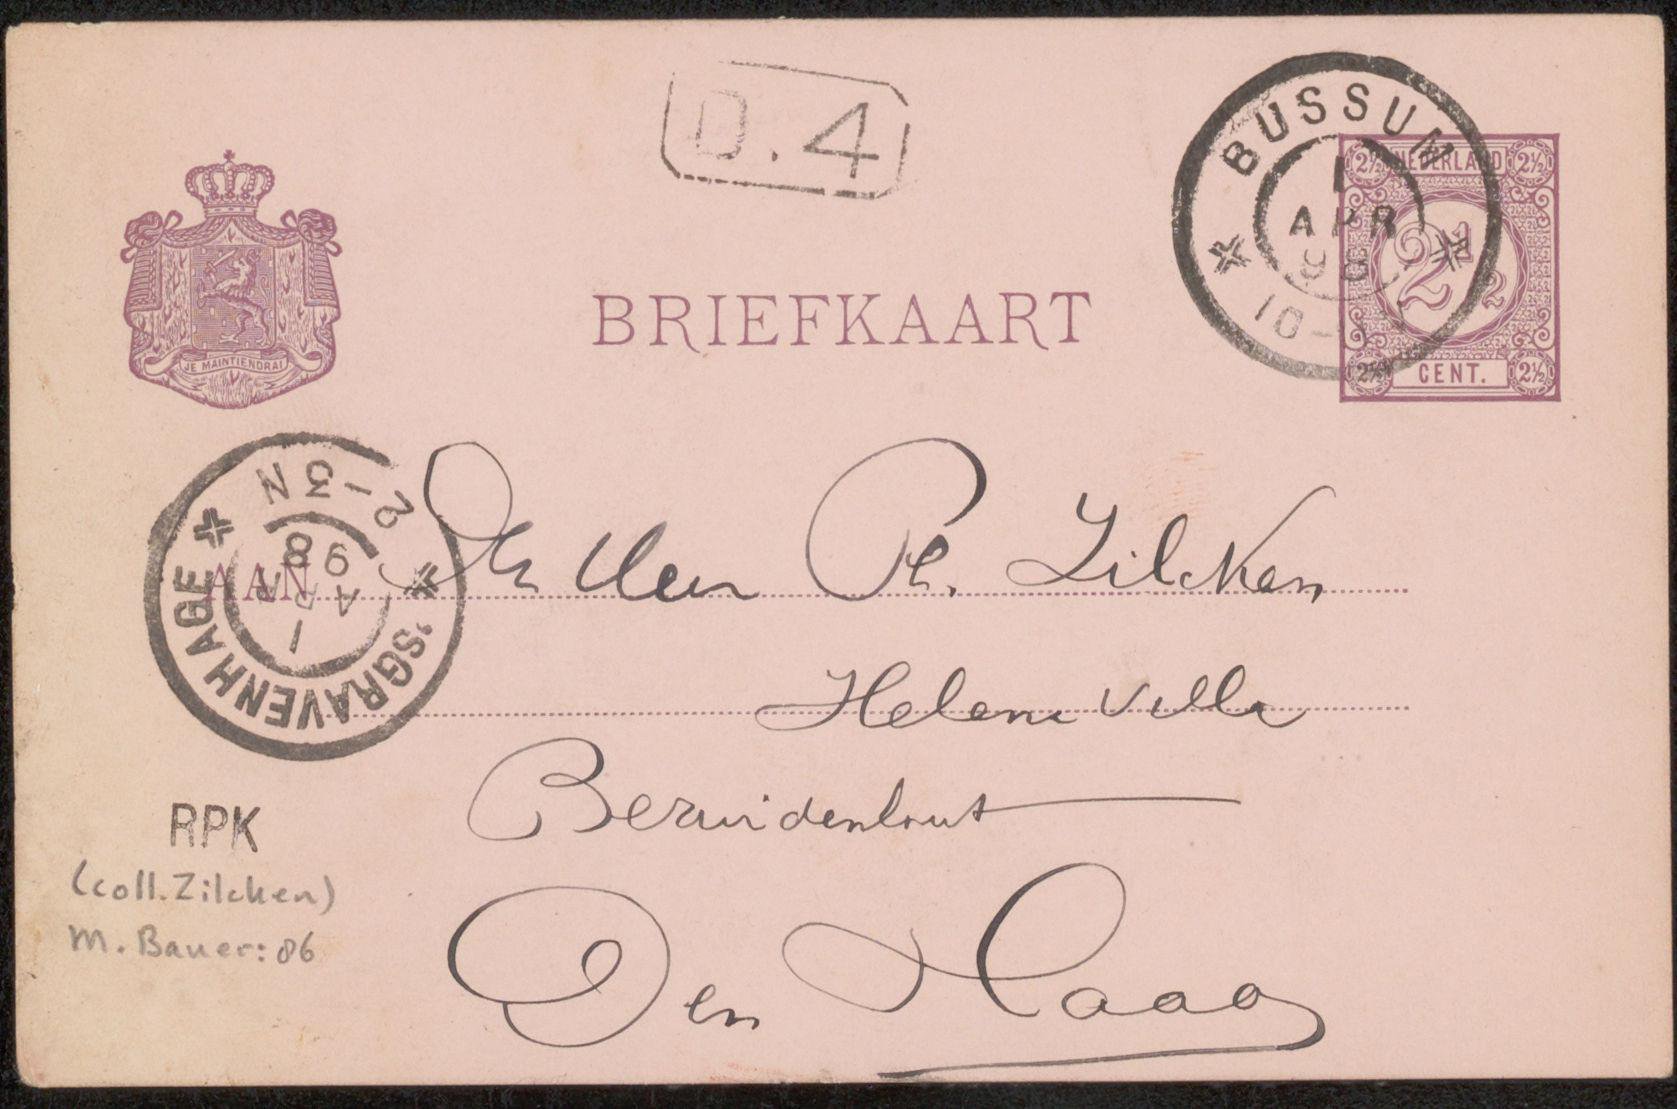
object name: postcard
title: Briefkaart aan Philip Zilcken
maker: marius bauer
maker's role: draughtsman, print maker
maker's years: 1867-1932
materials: cardboard, ink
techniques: pen, writing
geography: bussum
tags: willem witsen, martinus mouton, the hague, painter, draughtsman, philip zilcken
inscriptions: collector's mark: ‘RPK’